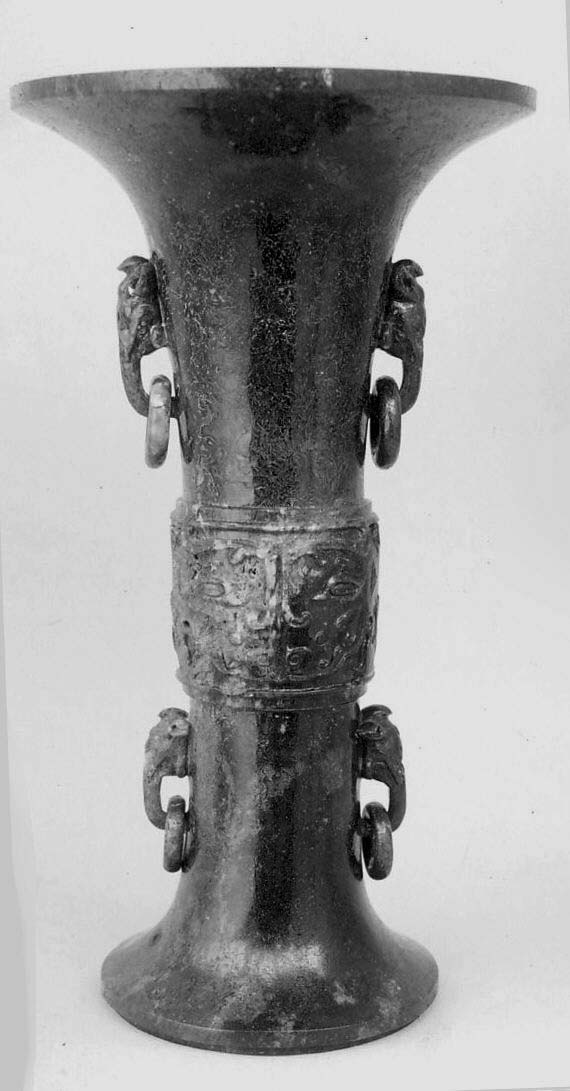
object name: vase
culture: chinese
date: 1736-1795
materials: stone